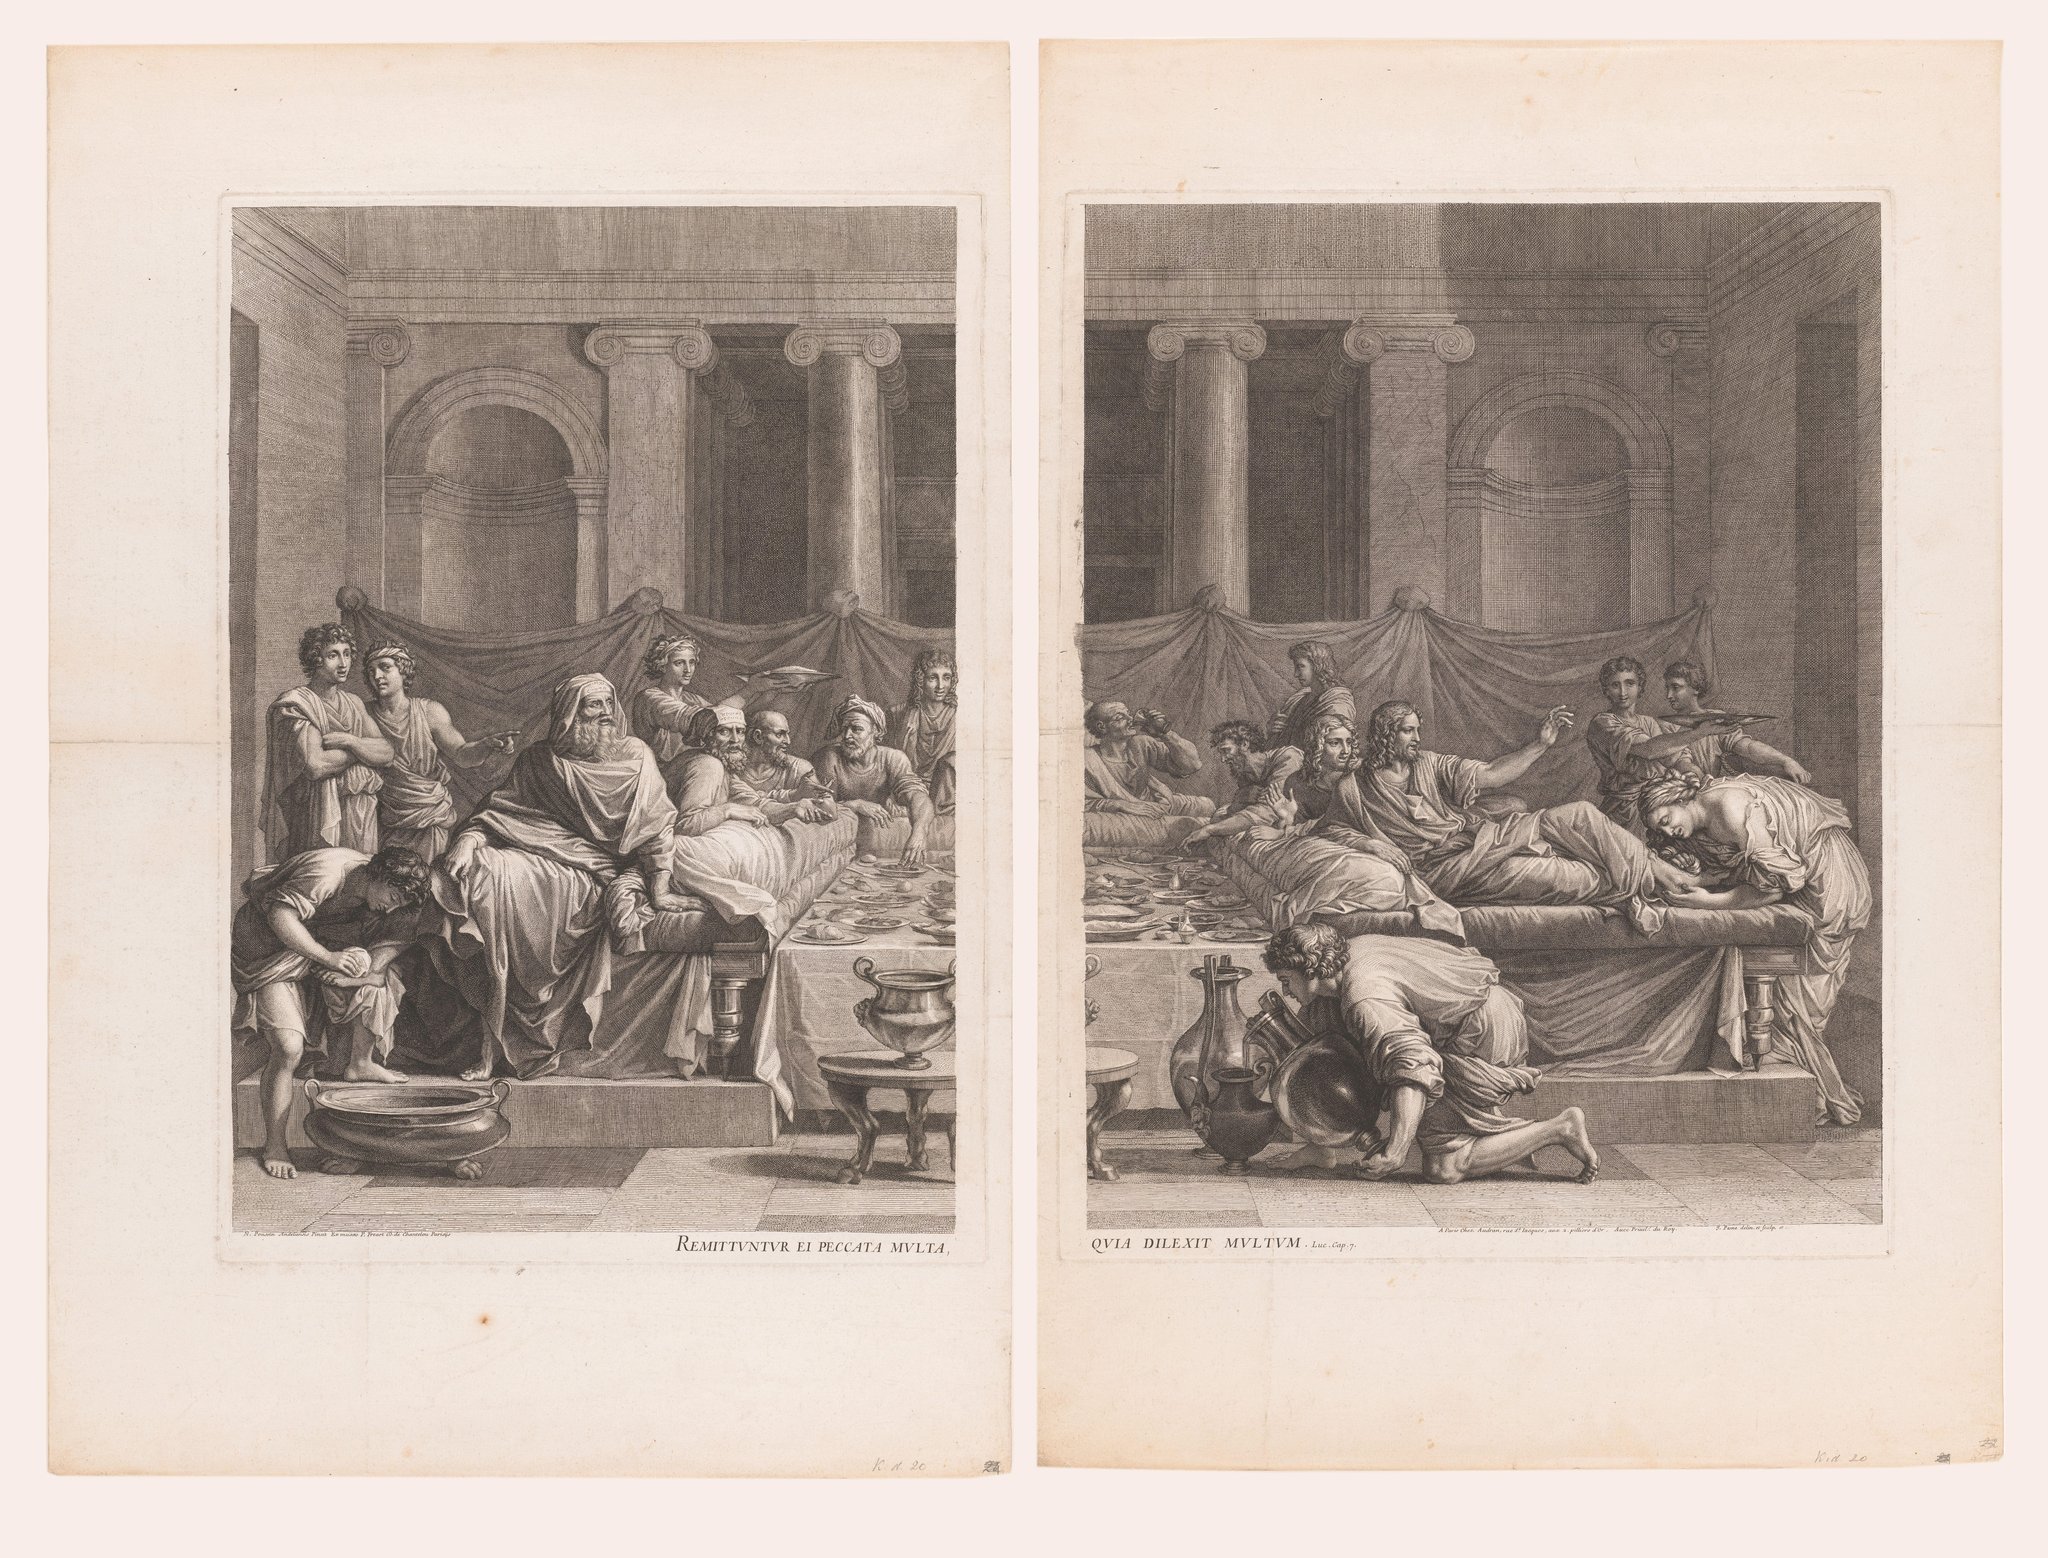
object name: print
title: Christus in het huis van Marta en Maria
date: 1680-1694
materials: paper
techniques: etching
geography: paris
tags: meal at the house of simon the pharisee (luke 7:36-50), christ's feet are anointed by mary (magdalene), confession; 'confessione sacramentale' (ripa) ~ the third of the seven sacraments, meal in bethany (at the house of simon the leper) (matthew 26:6-13; mark 14:3-9; john 12:1-11)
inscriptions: collector's mark: Lugt 240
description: Prent maakt deel uit van een ongenummerde serie van zeven prenten. Dit object is omwille van een betere presentatie virtueel samengevoegd, maar bestaat fysiek uit losse onderdelen.